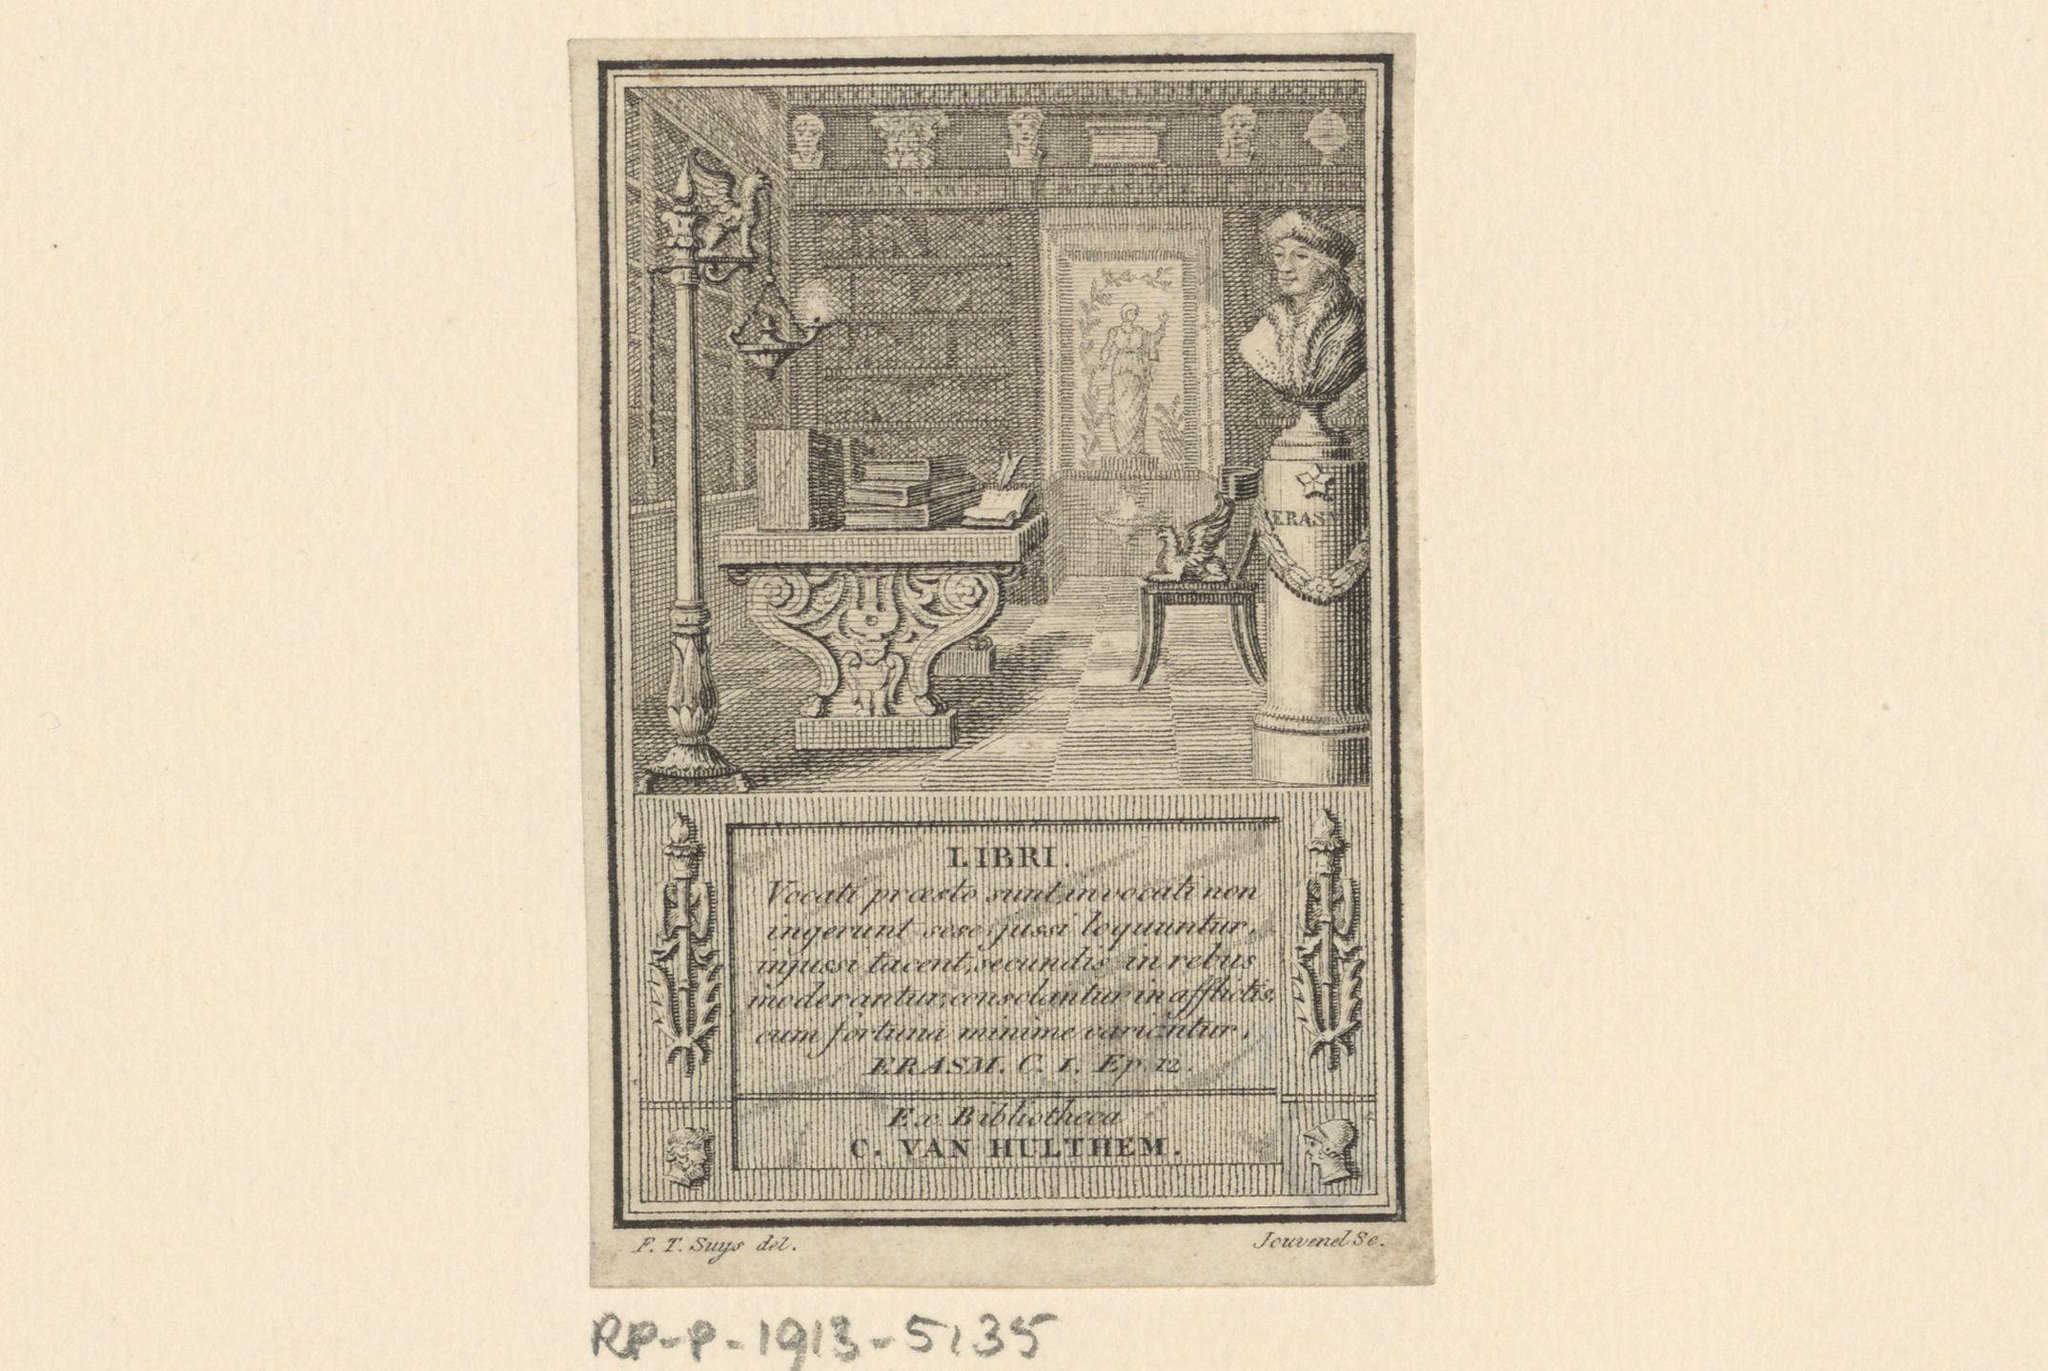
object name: bookplate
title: Ex bibliotheca C. Van Hulthem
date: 1793-1832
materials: paper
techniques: etching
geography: belgium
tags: rotterdam, desiderius erasmus, chest, bust, study; 'studiolo'; library, oil-lamp, sculpture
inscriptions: collector's mark: Lugt 2233, collector's mark: Lugt 2760